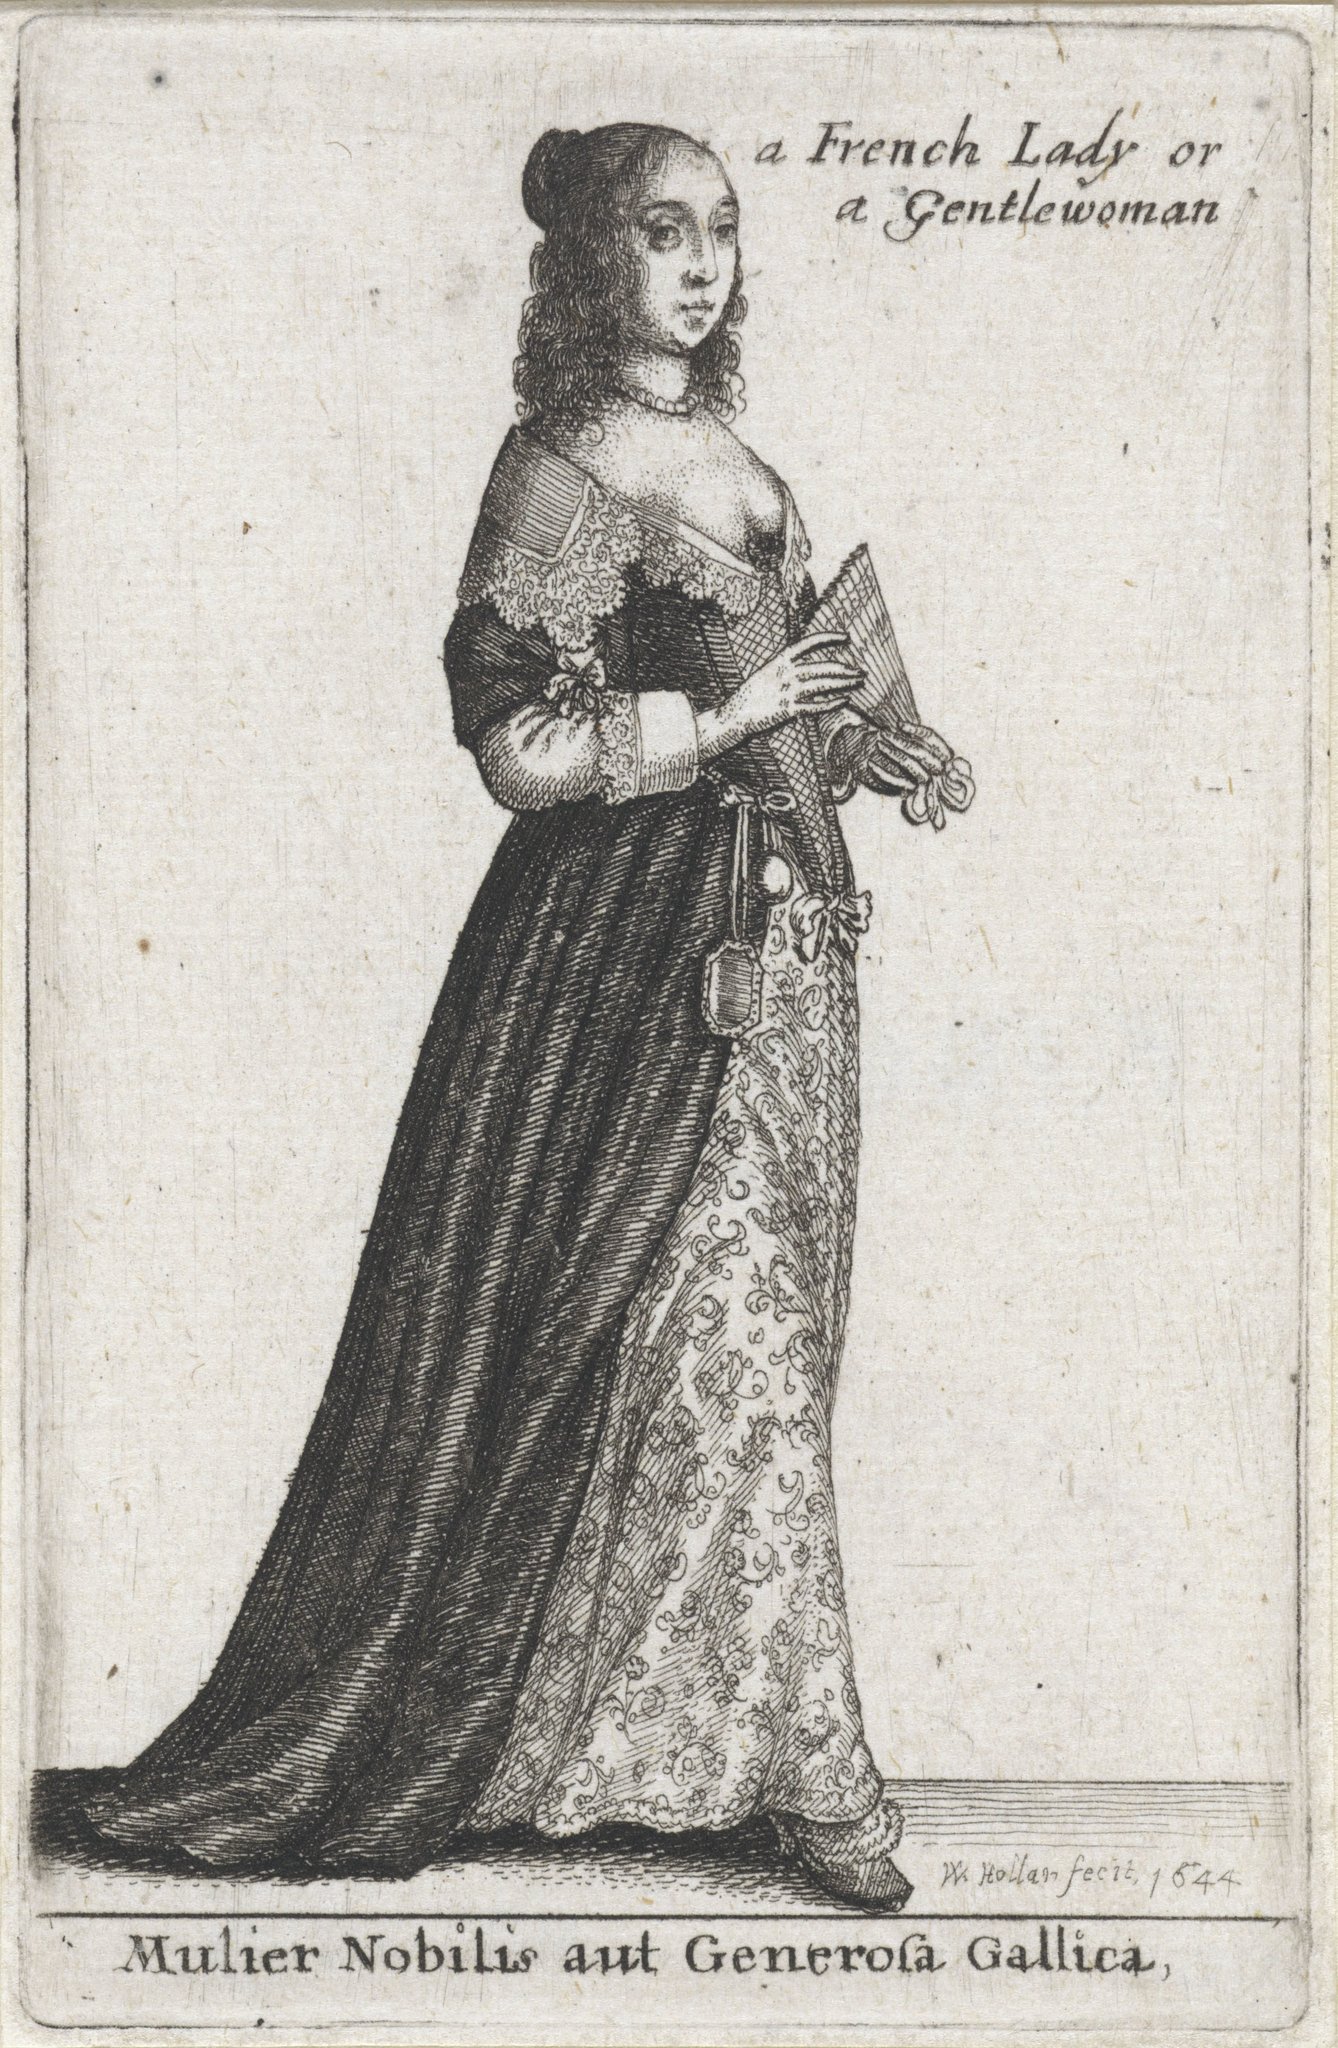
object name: costume print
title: Klederdracht van vrouwen uit verschillende landen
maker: wenceslaus hollar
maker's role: draughtsman, print maker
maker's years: 1607-1677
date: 1644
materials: paper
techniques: etching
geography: london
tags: styles of hairdress - aa - ~ women, 'décolleté', europeans: englishmen (+ costume), mirror - aa - (for) women, neck-gear: collar (+ women's clothes), shoes, sandals (+ women's clothes), fan (+ women's clothes), sleeves (+ women's clothes), pearl; pearl necklace (+ women's clothes), france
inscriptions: collector's mark: Lugt 240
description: Vrouw van aanzien uit Frankrijk, staand naar rechts, met losvallend haar dat op het achterhoofd in een knotje is gedraaid. Japon met diep decolleté en brede kraag, afgezet met kant, over de schouders. Het donkere overkleed valt van voren open zodat het brokaten onderkleed is te zien. Aan de ceintuur hangt een spiegeltje, vouwwaaier in de handen. Schoen met rozet. No. 1 uit serie van 12 kostuumprenten uit verschillende landen.